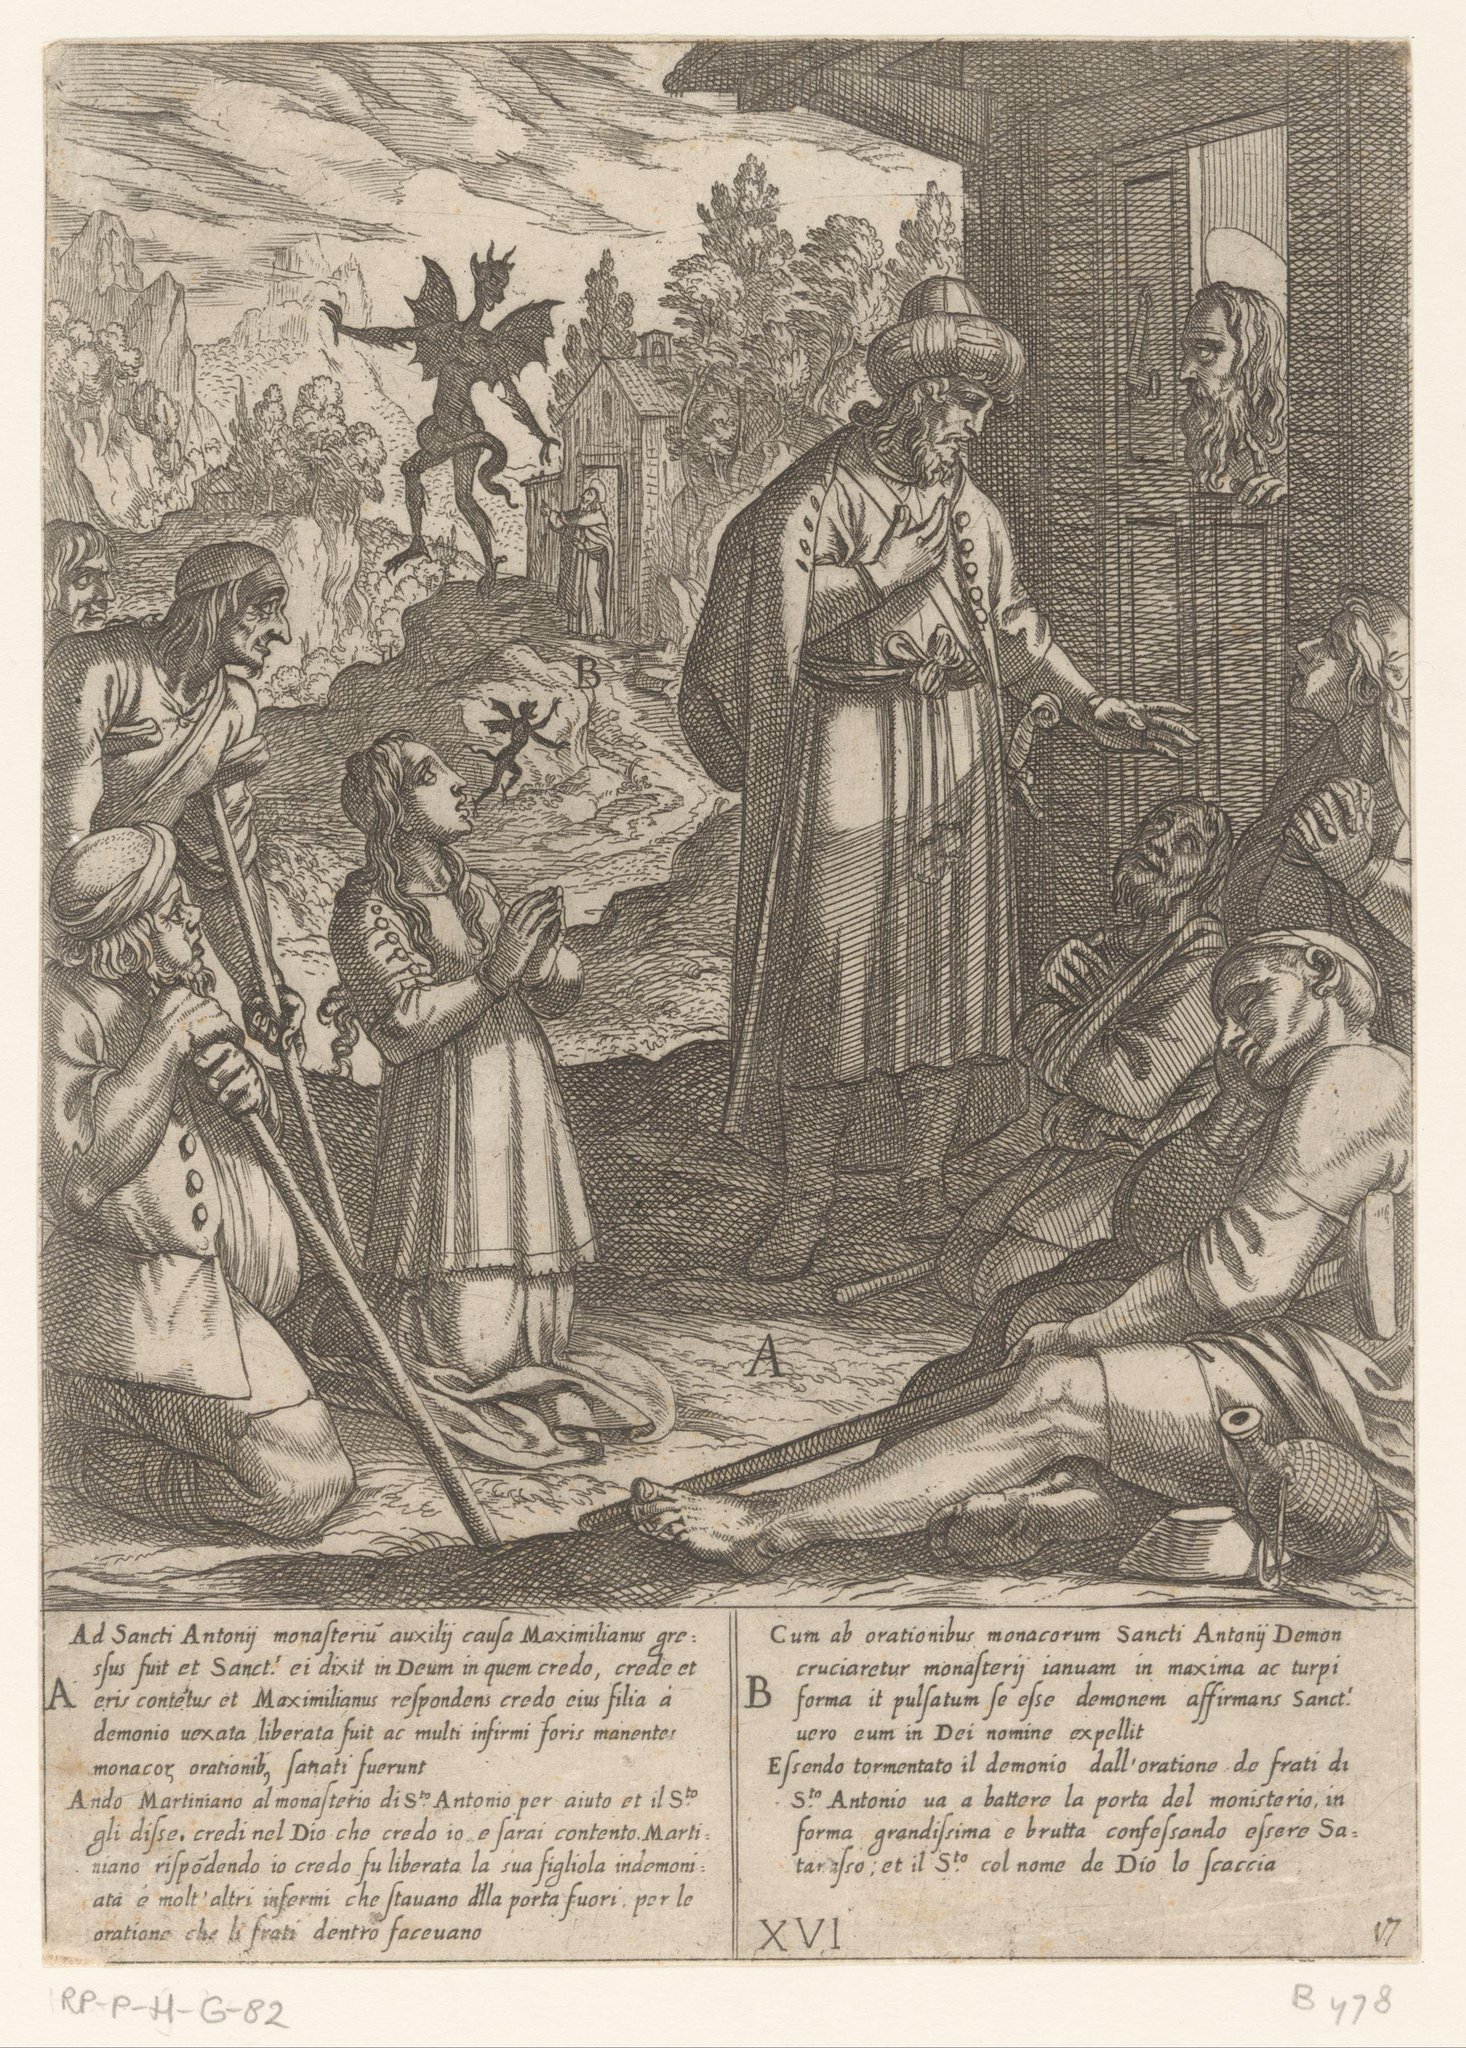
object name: print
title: Maximilianus vraagt H. Antonius zijn dochter te genezen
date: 1598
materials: paper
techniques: etching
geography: rome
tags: the hermit antony abbot (antonius abbas) of egypt, also called the great; possible attributes: bell, book, t-shaped staff, flames, pig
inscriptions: number: ‘17’, collector's mark: ‘Hinloopen’, collector's mark: Lugt 11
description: Deze prent maakt deel uit van een reeks van 27 prenten (+ titelprent) over het leven van de heilige Antonius, naar een frescocyclus in de S. Antonio Abbate in Rome door Giovanni Battista Lombardelli en Niccolò Circignani.